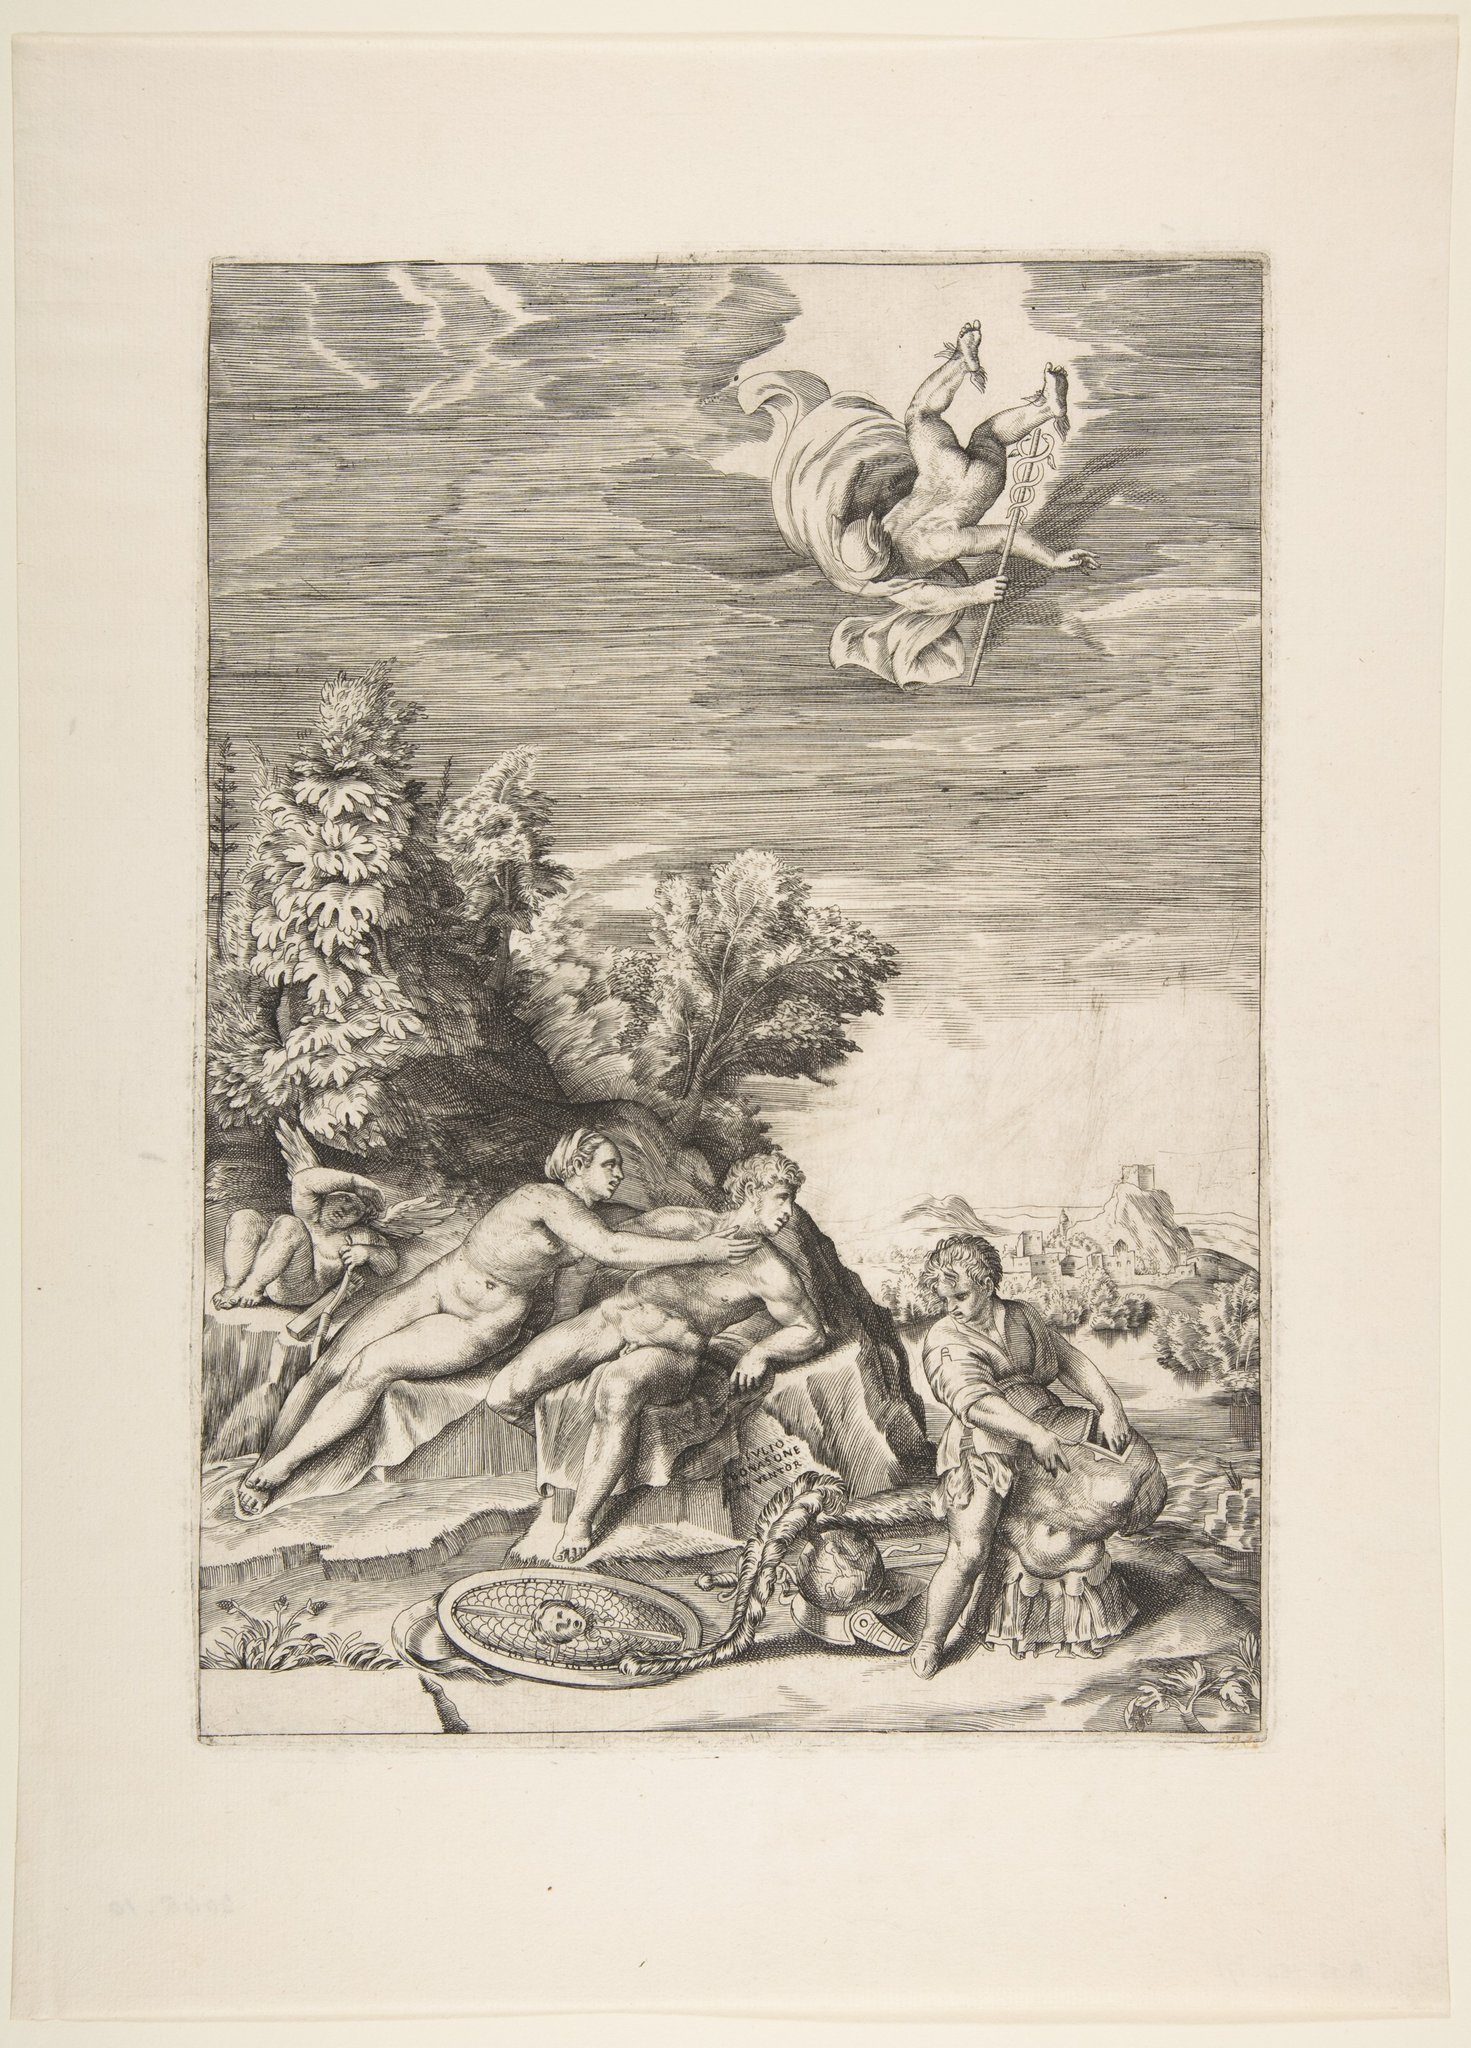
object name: print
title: Calypso trying to detain Ulysses as a child prepares his armour at right and Mercury falls from the sky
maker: giulio bonasone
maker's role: artist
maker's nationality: italian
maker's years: 1510-1576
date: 1531-1576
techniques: engraving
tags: male nudes,female nudes,mercury